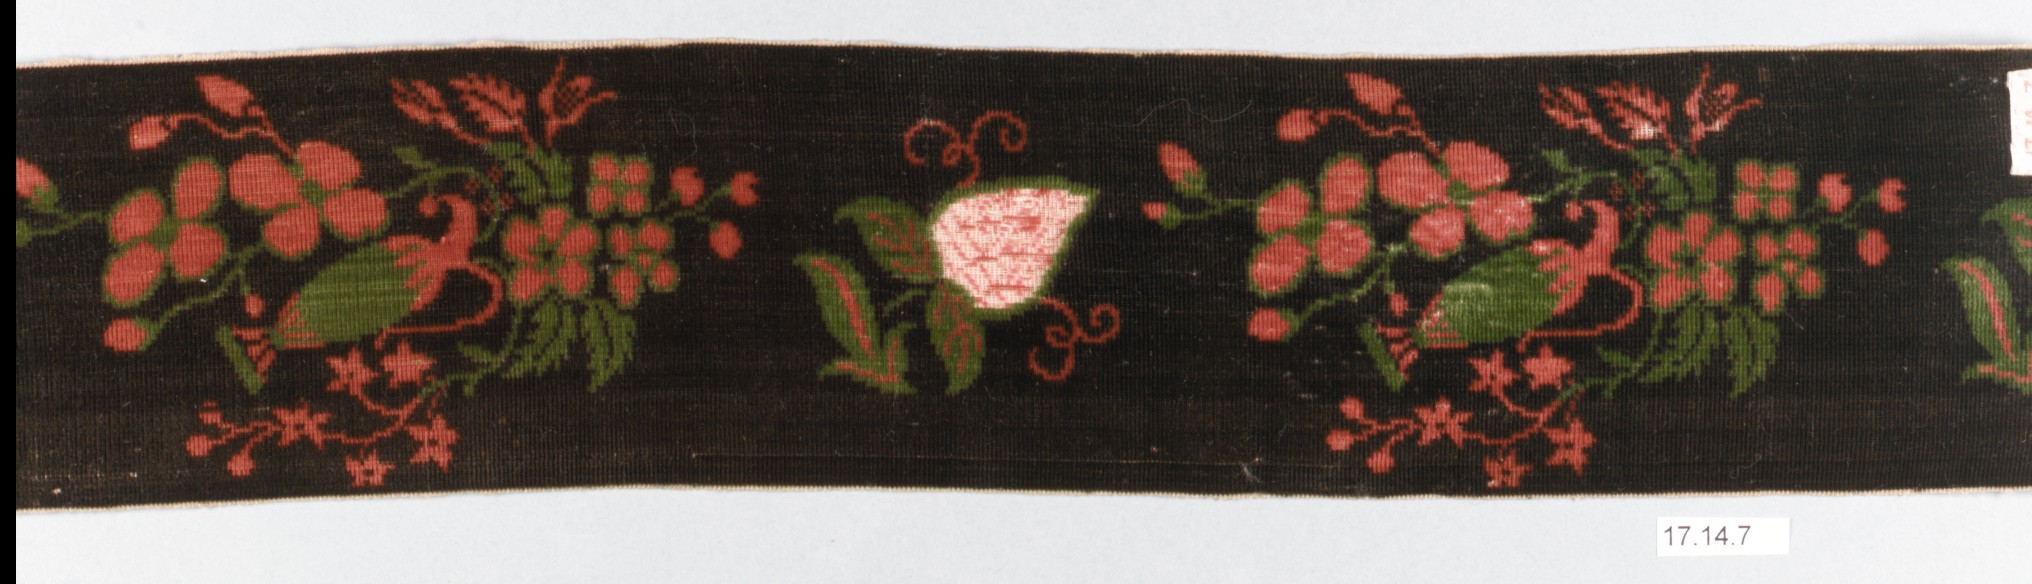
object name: ribbon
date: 1701-1800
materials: velvet